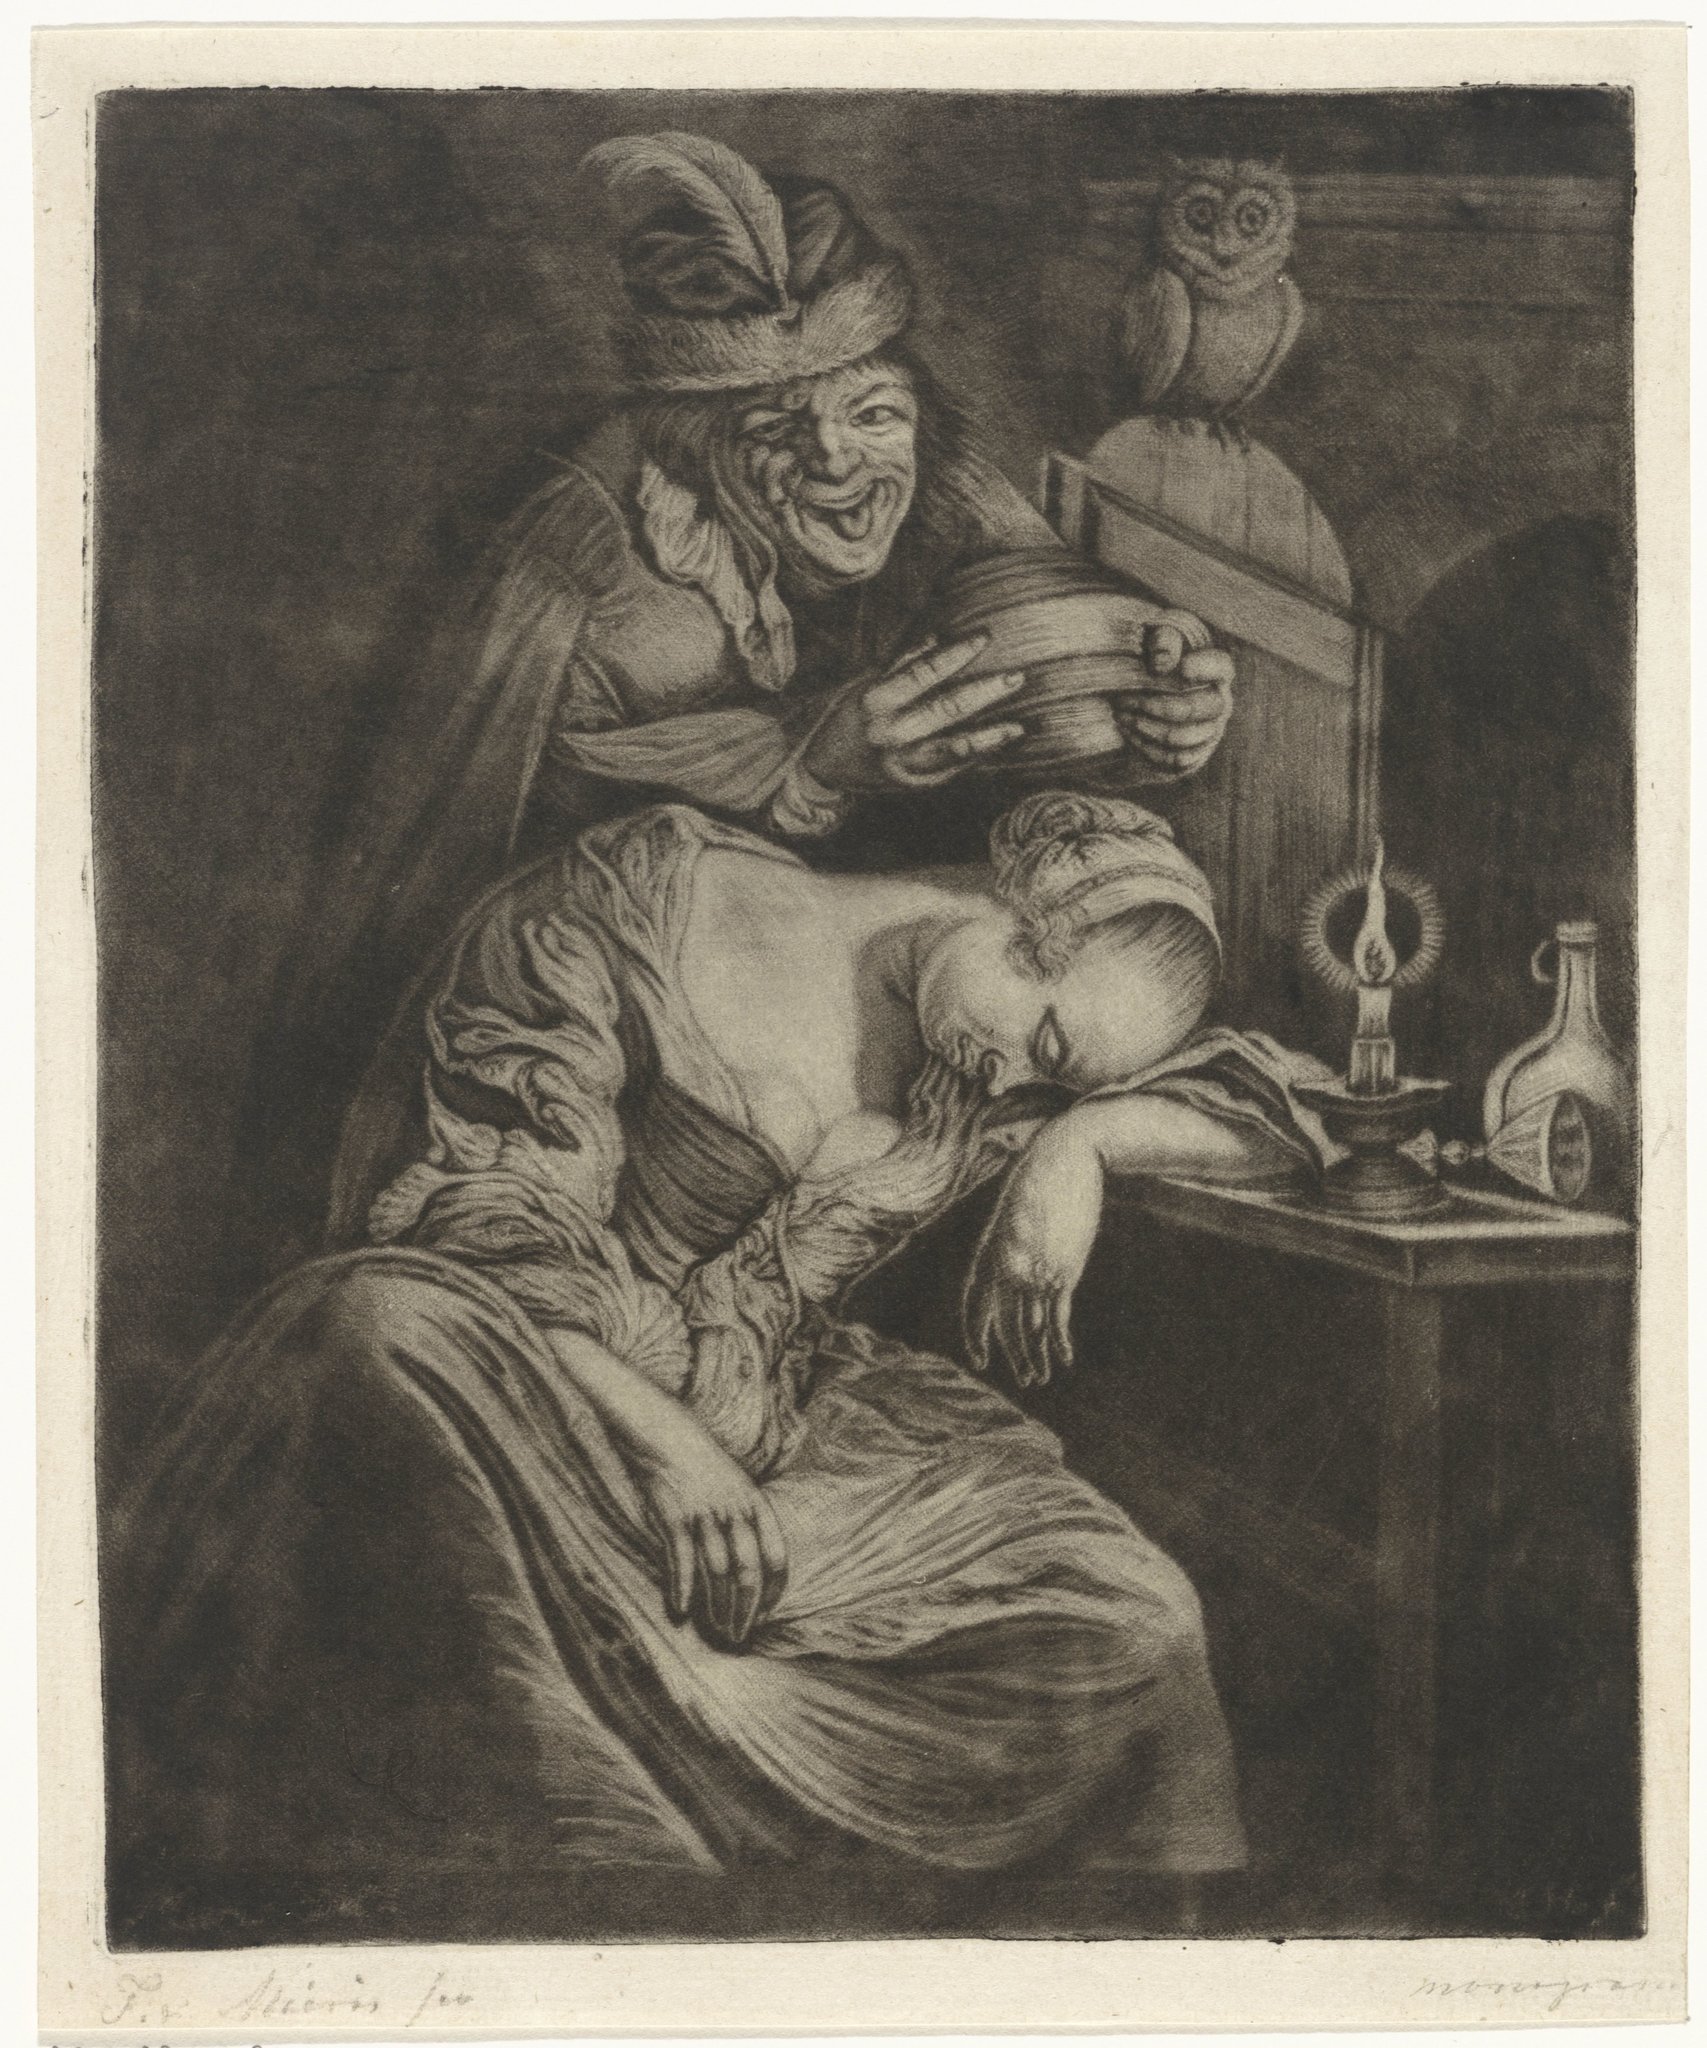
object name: print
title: De wijn is een spotter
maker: jacob hoolaart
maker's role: print maker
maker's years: 1713-1789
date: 1723-1789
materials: paper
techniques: mezzotint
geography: dordrecht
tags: proverbs, sayings, etc., candle, drunkenness, chamber-pot, 'wine is a mocker ...' ~ drunken brawl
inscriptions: collector's mark: Lugt 2228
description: Een nar-achtige figuur staat op het punt om een slapende vrouw een pispot op het hoofd te zetten. Hij steekt zijn tong uit. Op de tafel, waar de vrouw haar hoofd op te rusten heeft gelegd, ligt een omgevallen wijnglas. Op de deur van het venster zit een uil.